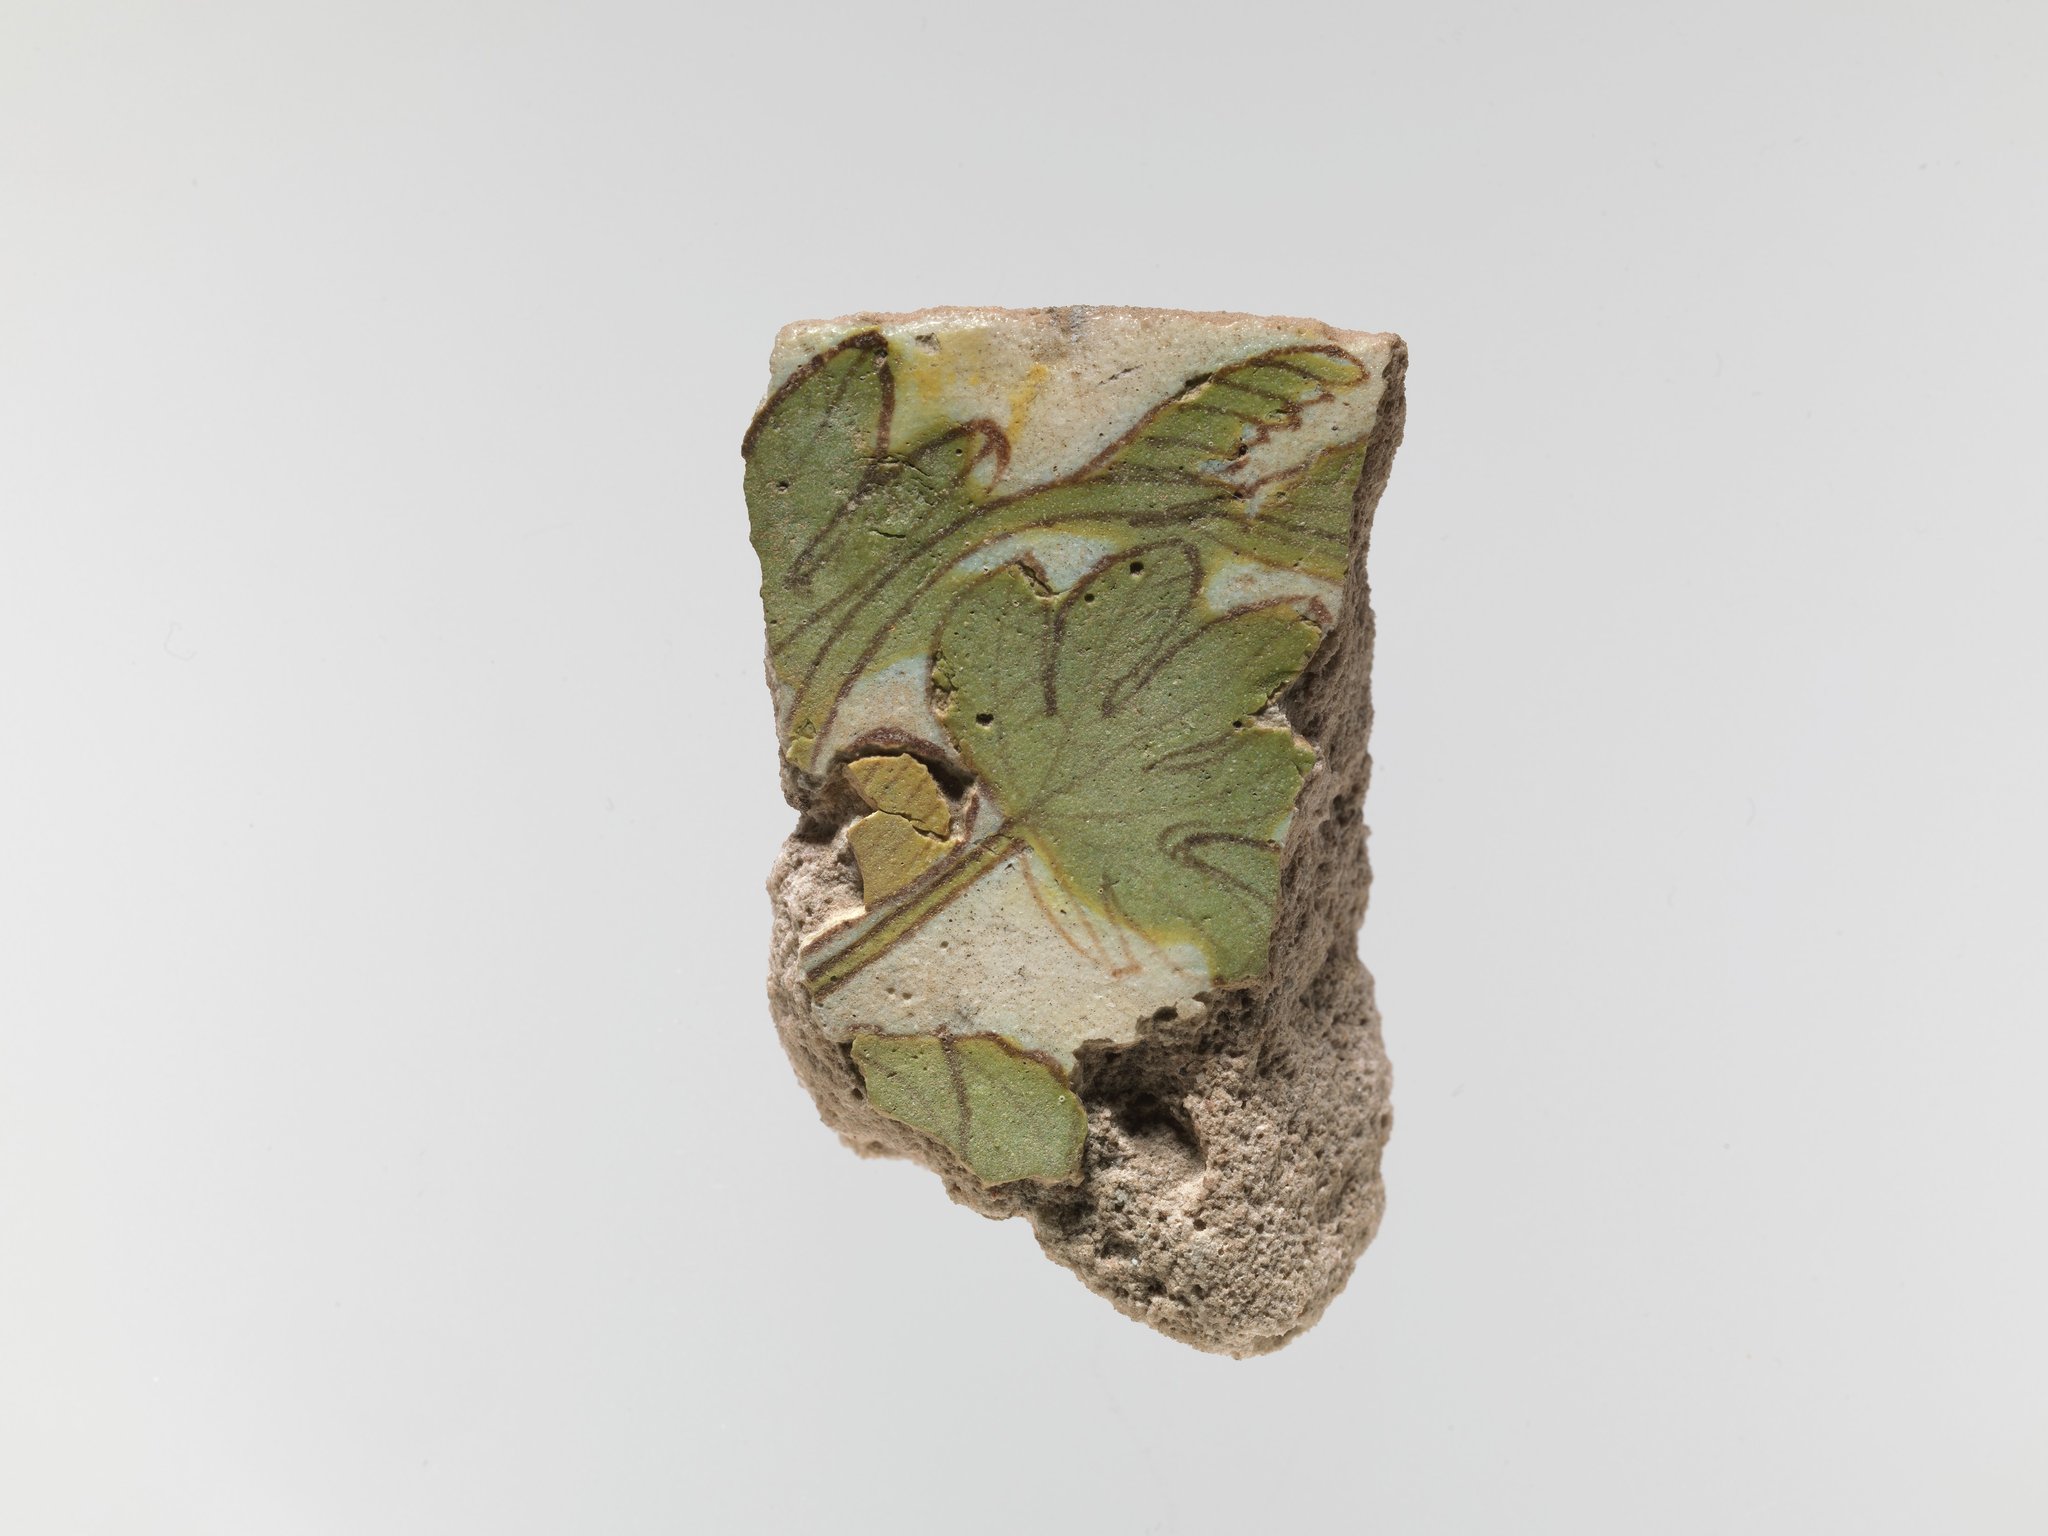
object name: tile fragment, marsh scene, bird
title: Tile from marsh scene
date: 1353-1336 BCE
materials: faience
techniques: polychrome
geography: egypt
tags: leaves